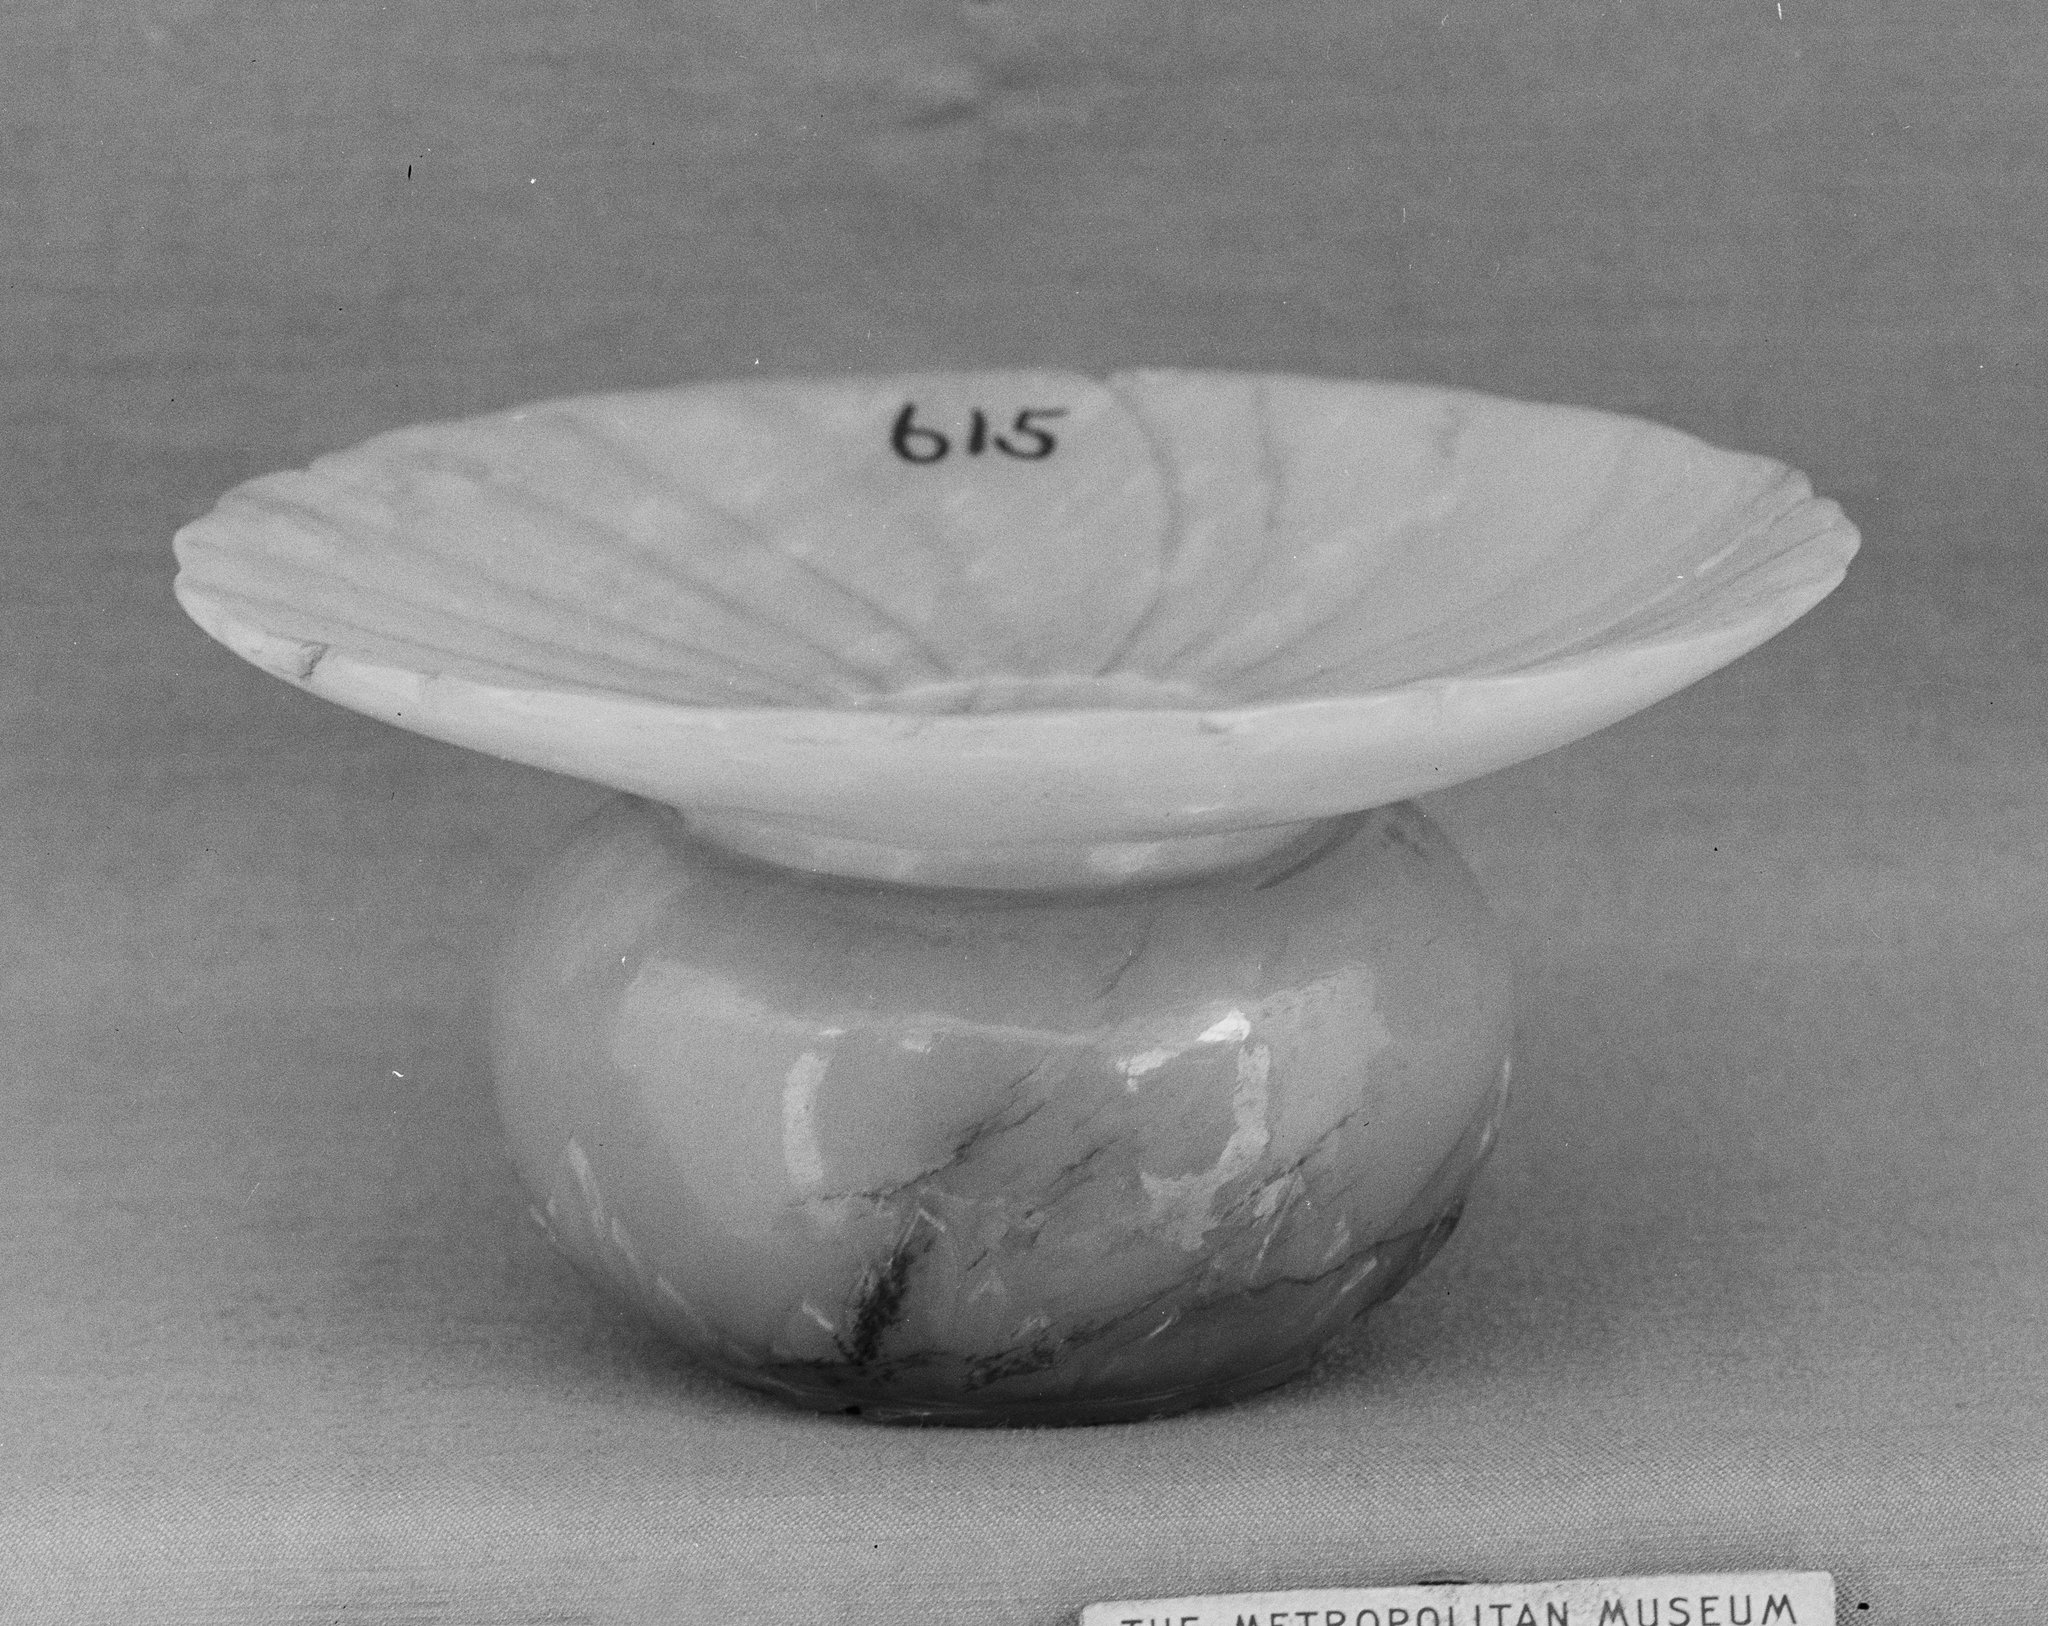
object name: vase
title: Miniature Vase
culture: chinese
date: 1736-1795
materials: jade